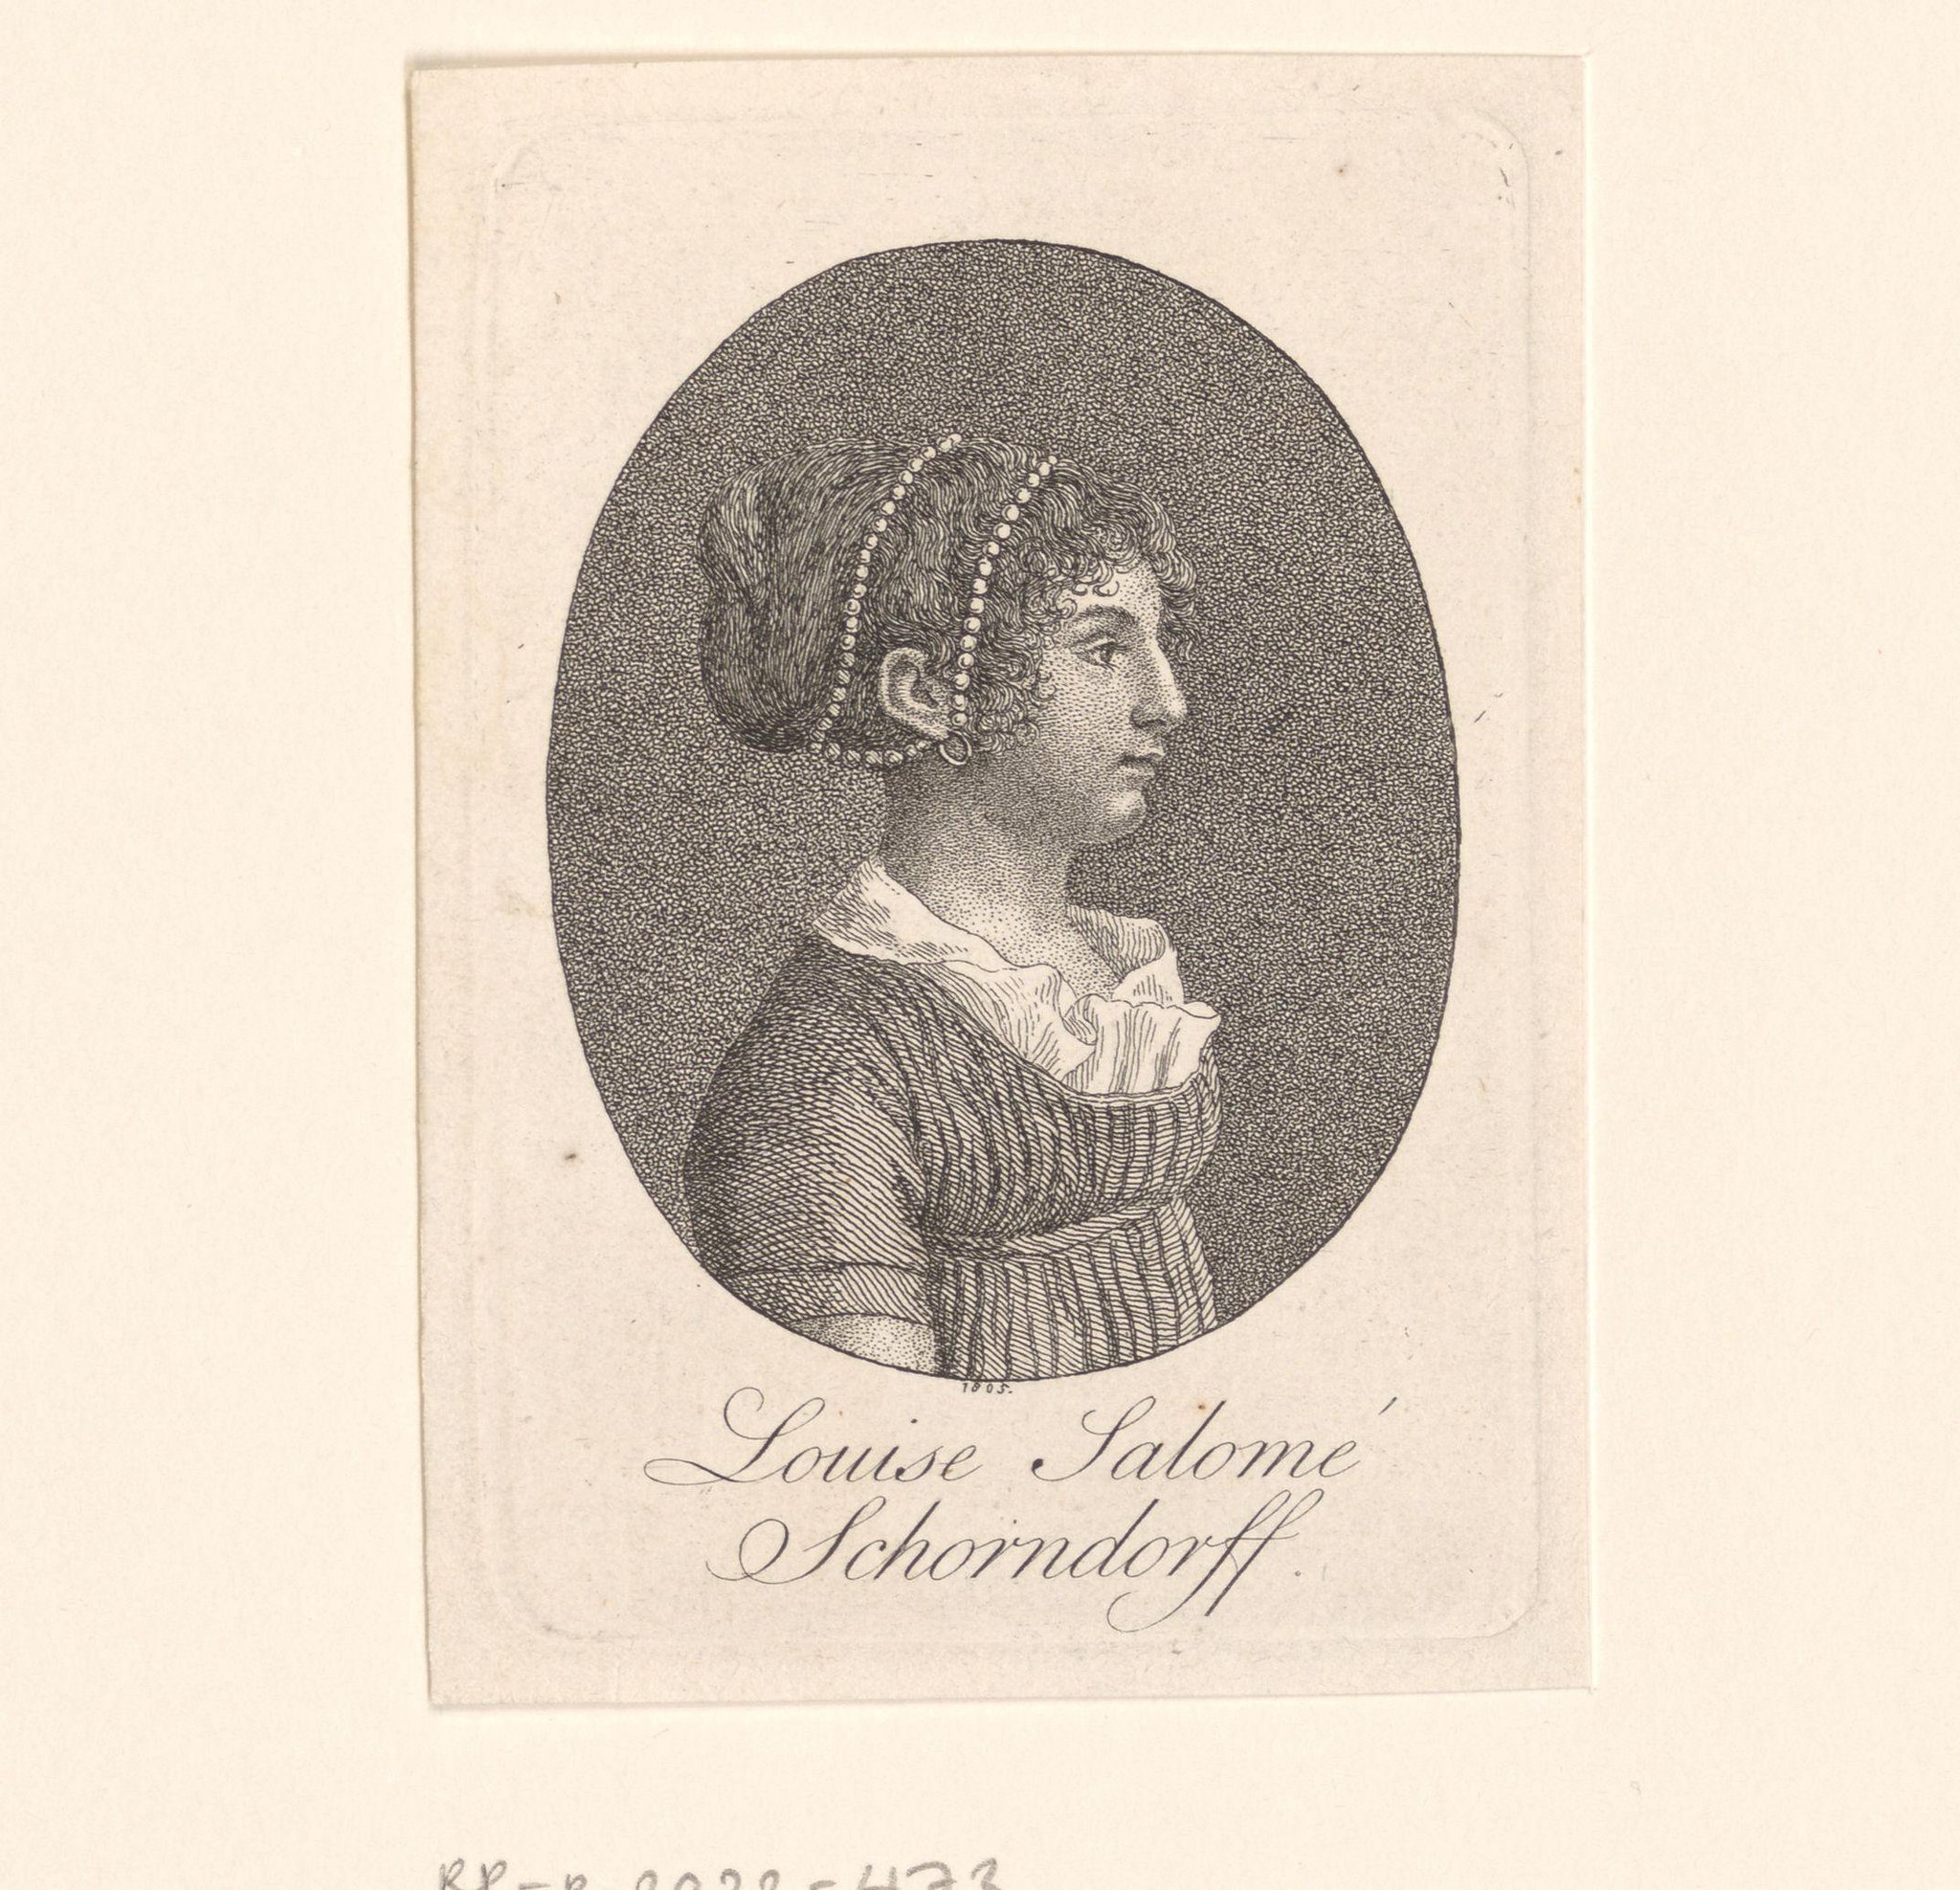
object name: print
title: Portret van Louise Salomé Schorndorff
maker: Anonymous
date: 1805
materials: paper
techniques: etching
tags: historical persons - bb - woman, professor